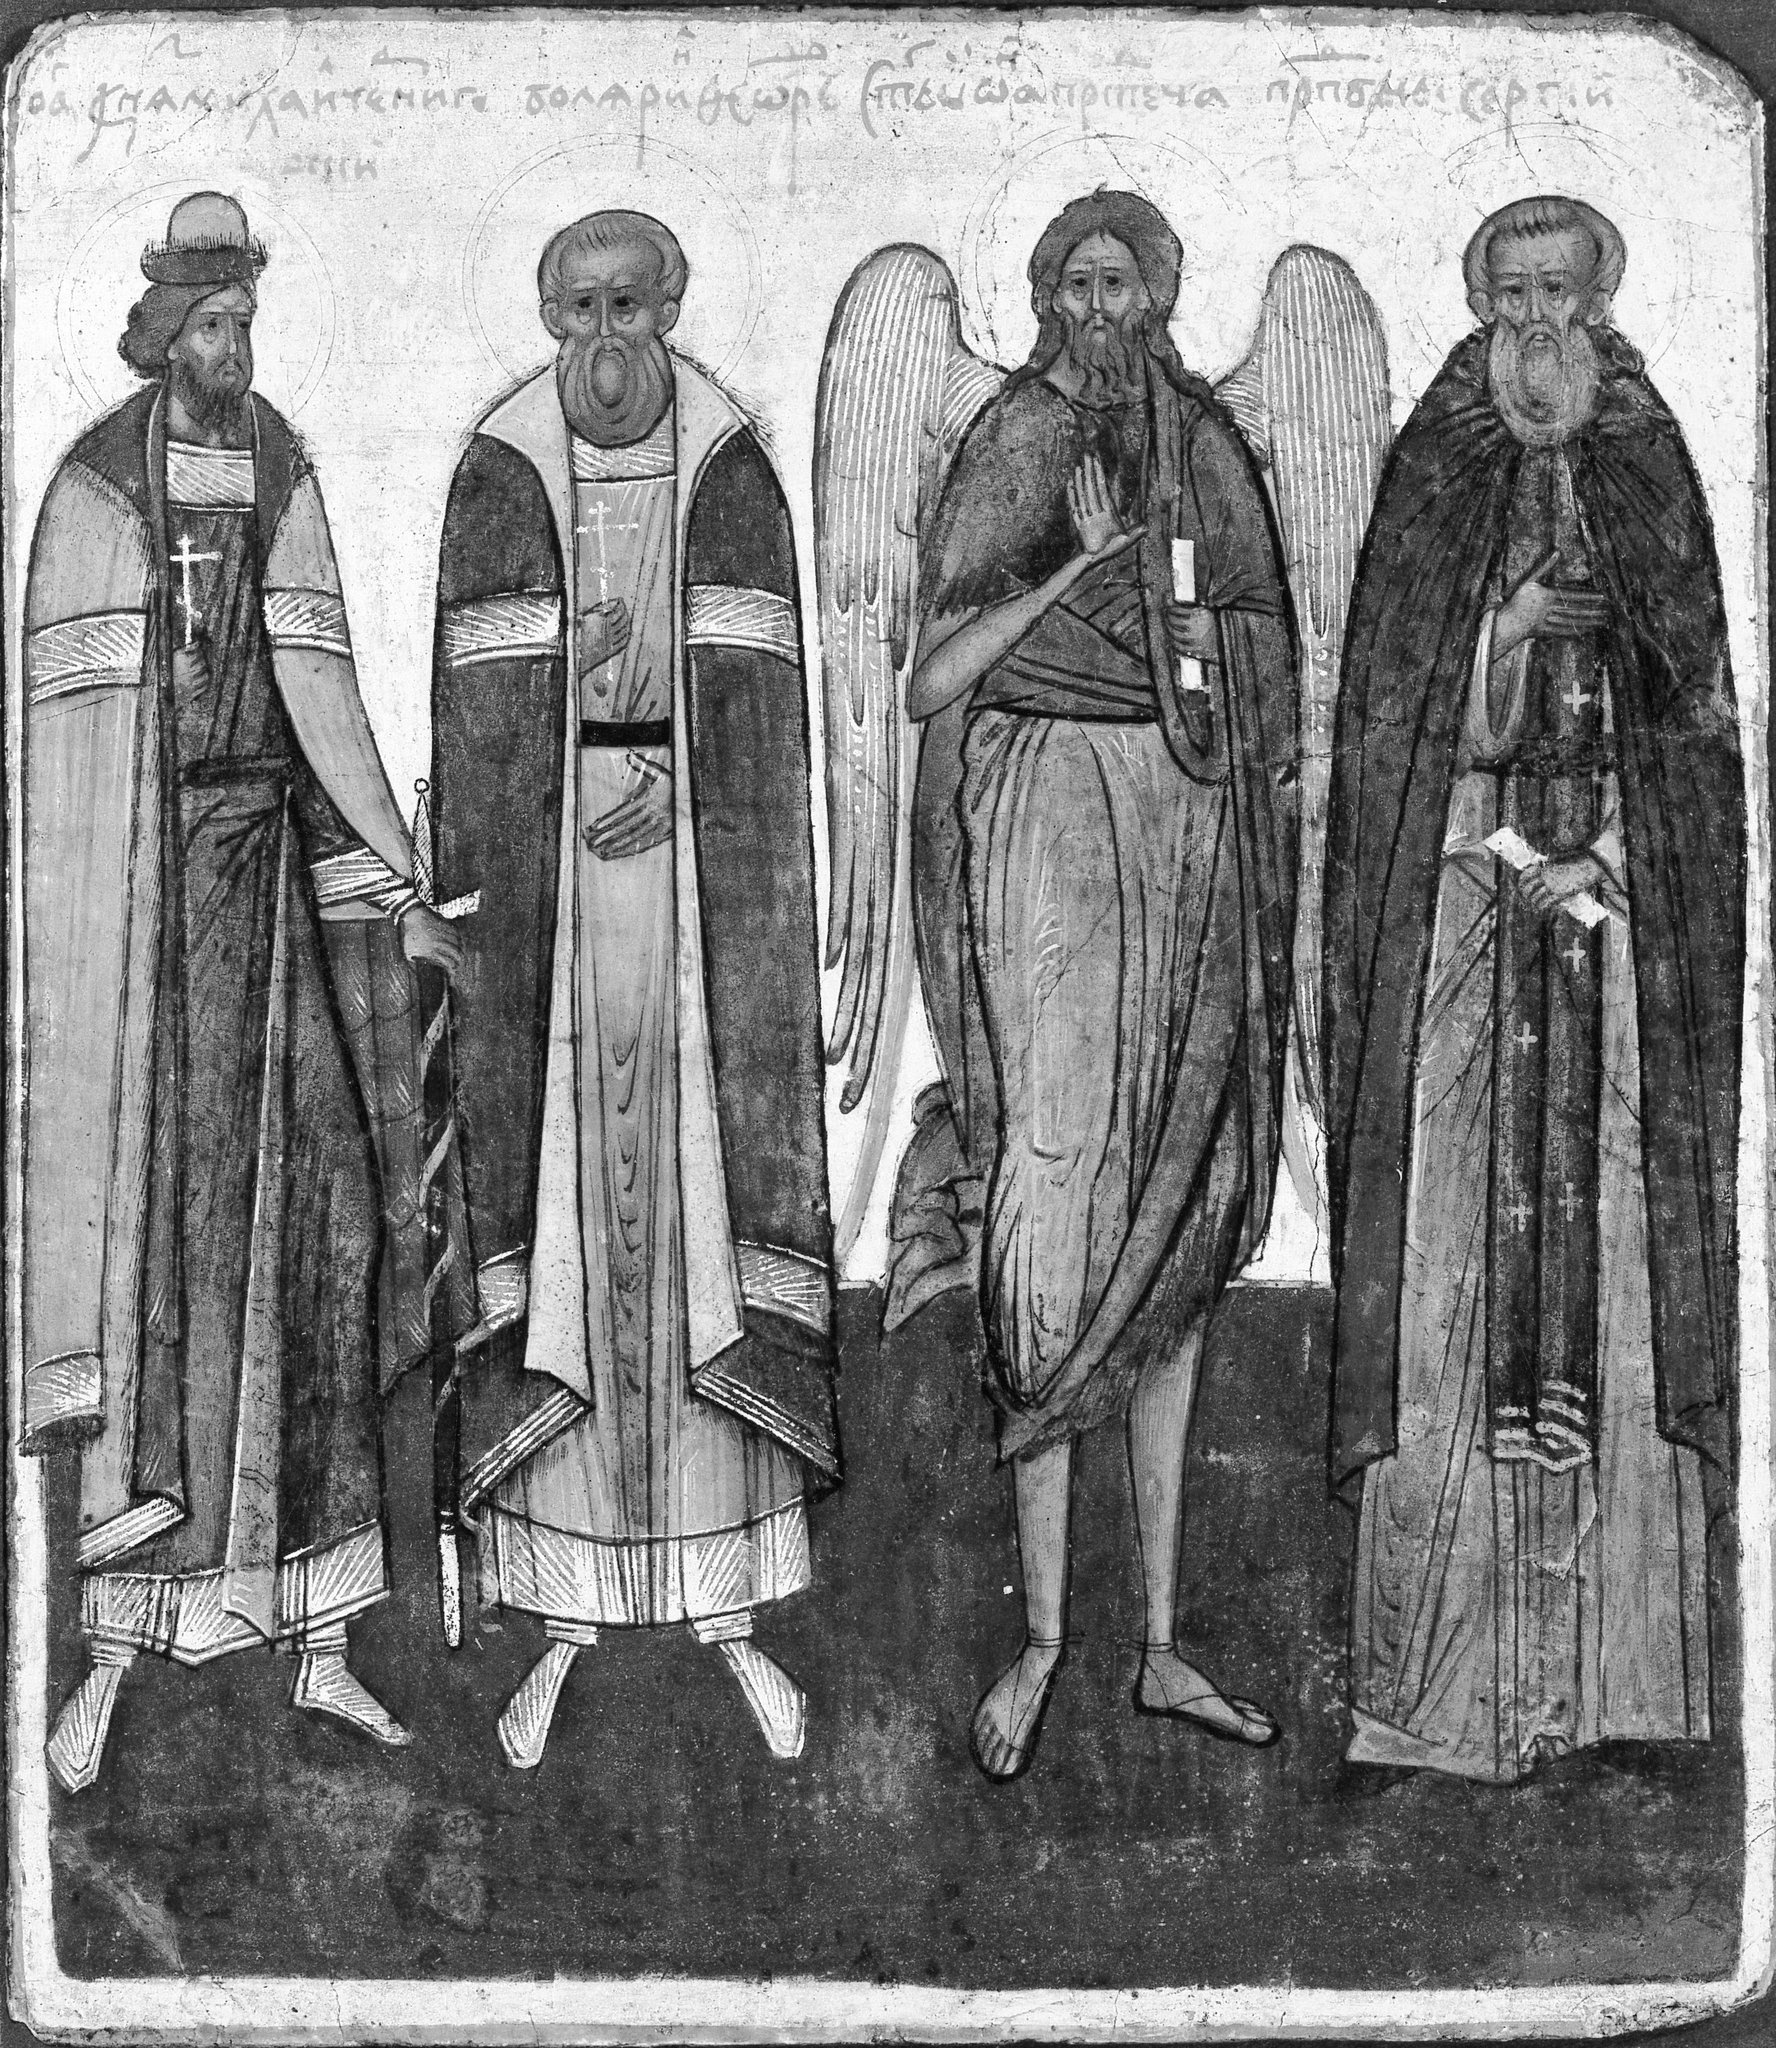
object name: painting, icon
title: Panel from a Saints' Calendar (painted on both sides)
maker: russian painter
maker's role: artist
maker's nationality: russian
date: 1500-1599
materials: linen, paint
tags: men,saints